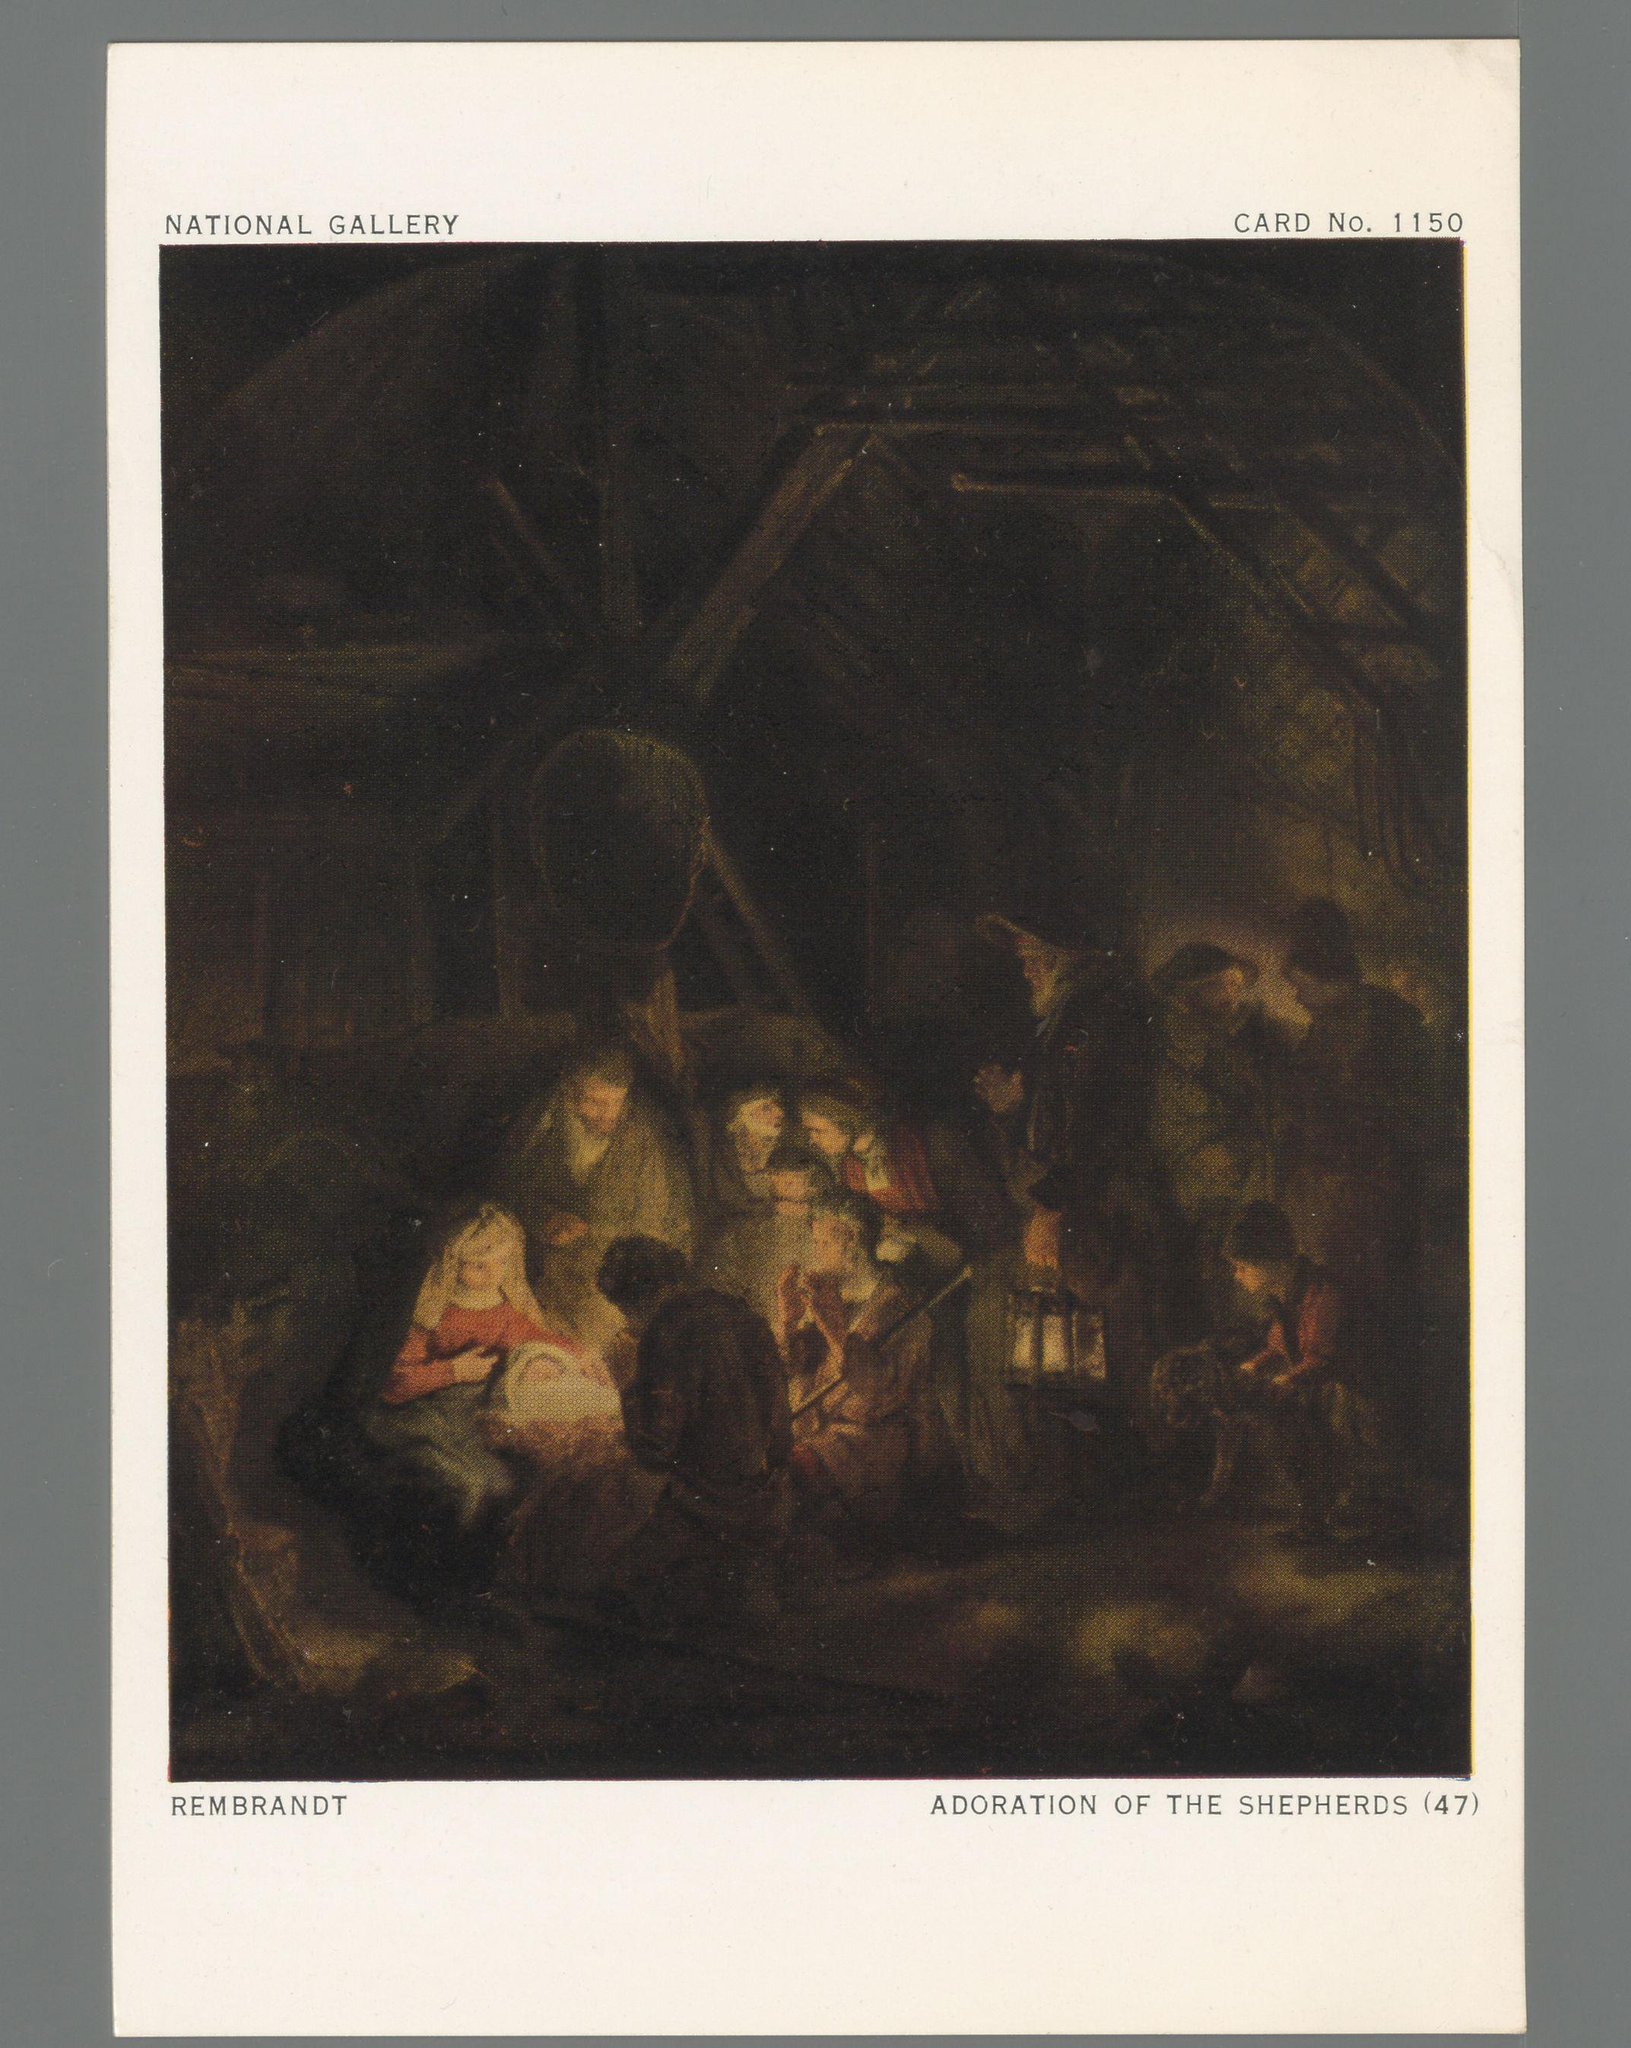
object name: ansichtkaart, prentbriefkaart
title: National Gallery. Rembrandt. Adoration of the shepherds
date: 1902-1950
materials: cardboard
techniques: writing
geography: london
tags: permanent exhibition, museum, picture, painting